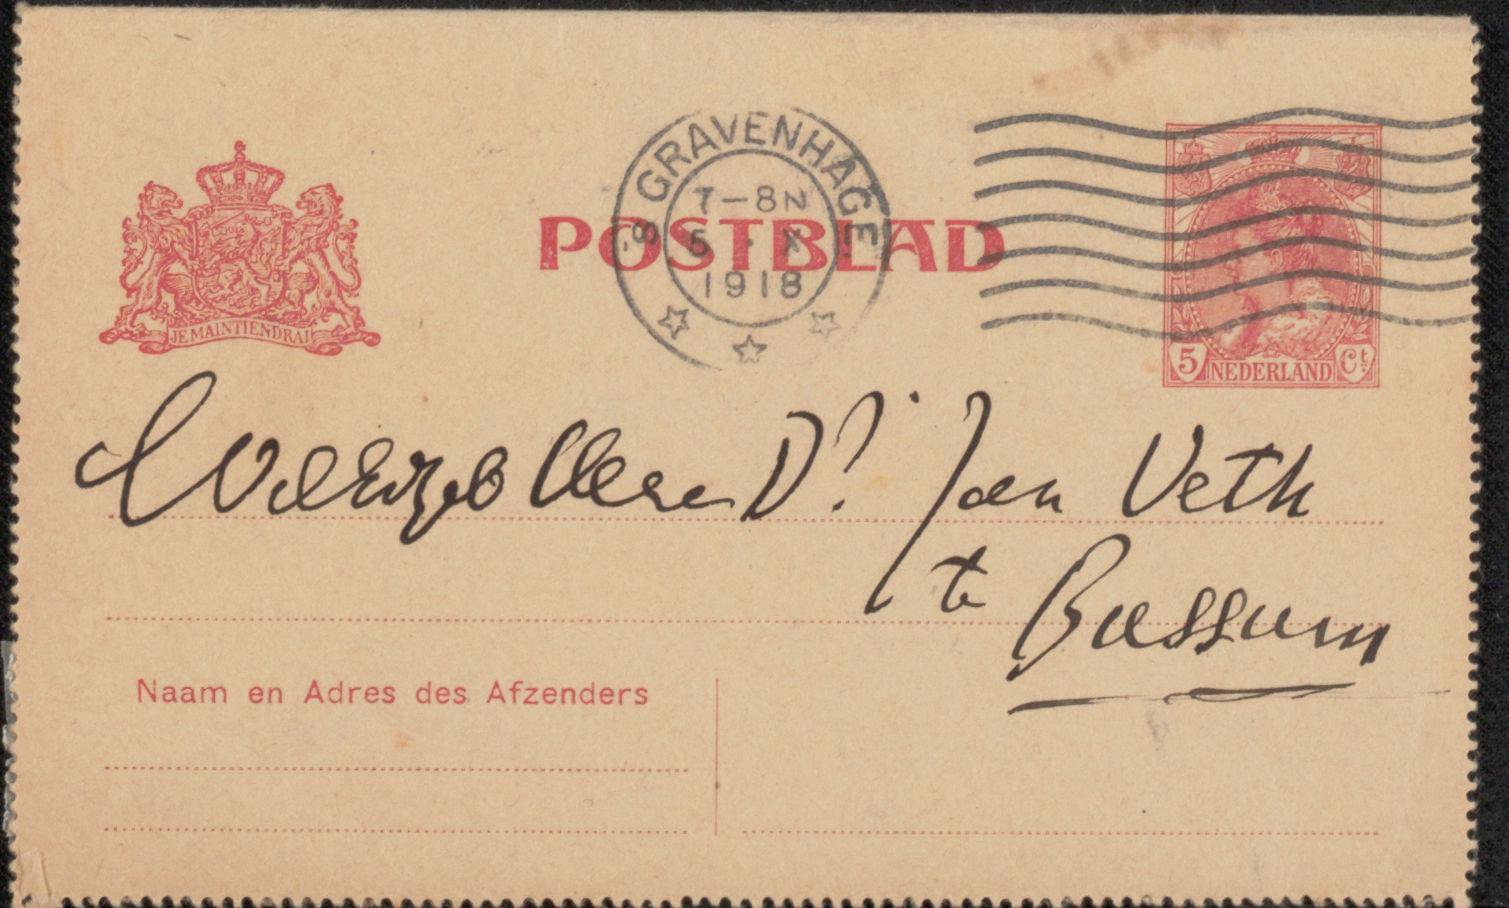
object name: letter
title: Brief aan Jan Veth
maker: isaac israels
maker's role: draughtsman, painter, print maker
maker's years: 1865-1934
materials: ink, paper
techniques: pen, writing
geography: the hague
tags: dordrecht, painter, designer, jan veth, the hague, print maker, draughtsman, marius bauer, willem van konijnenburg, haarlem, georg rueter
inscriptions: collector's mark: ‘RPK’